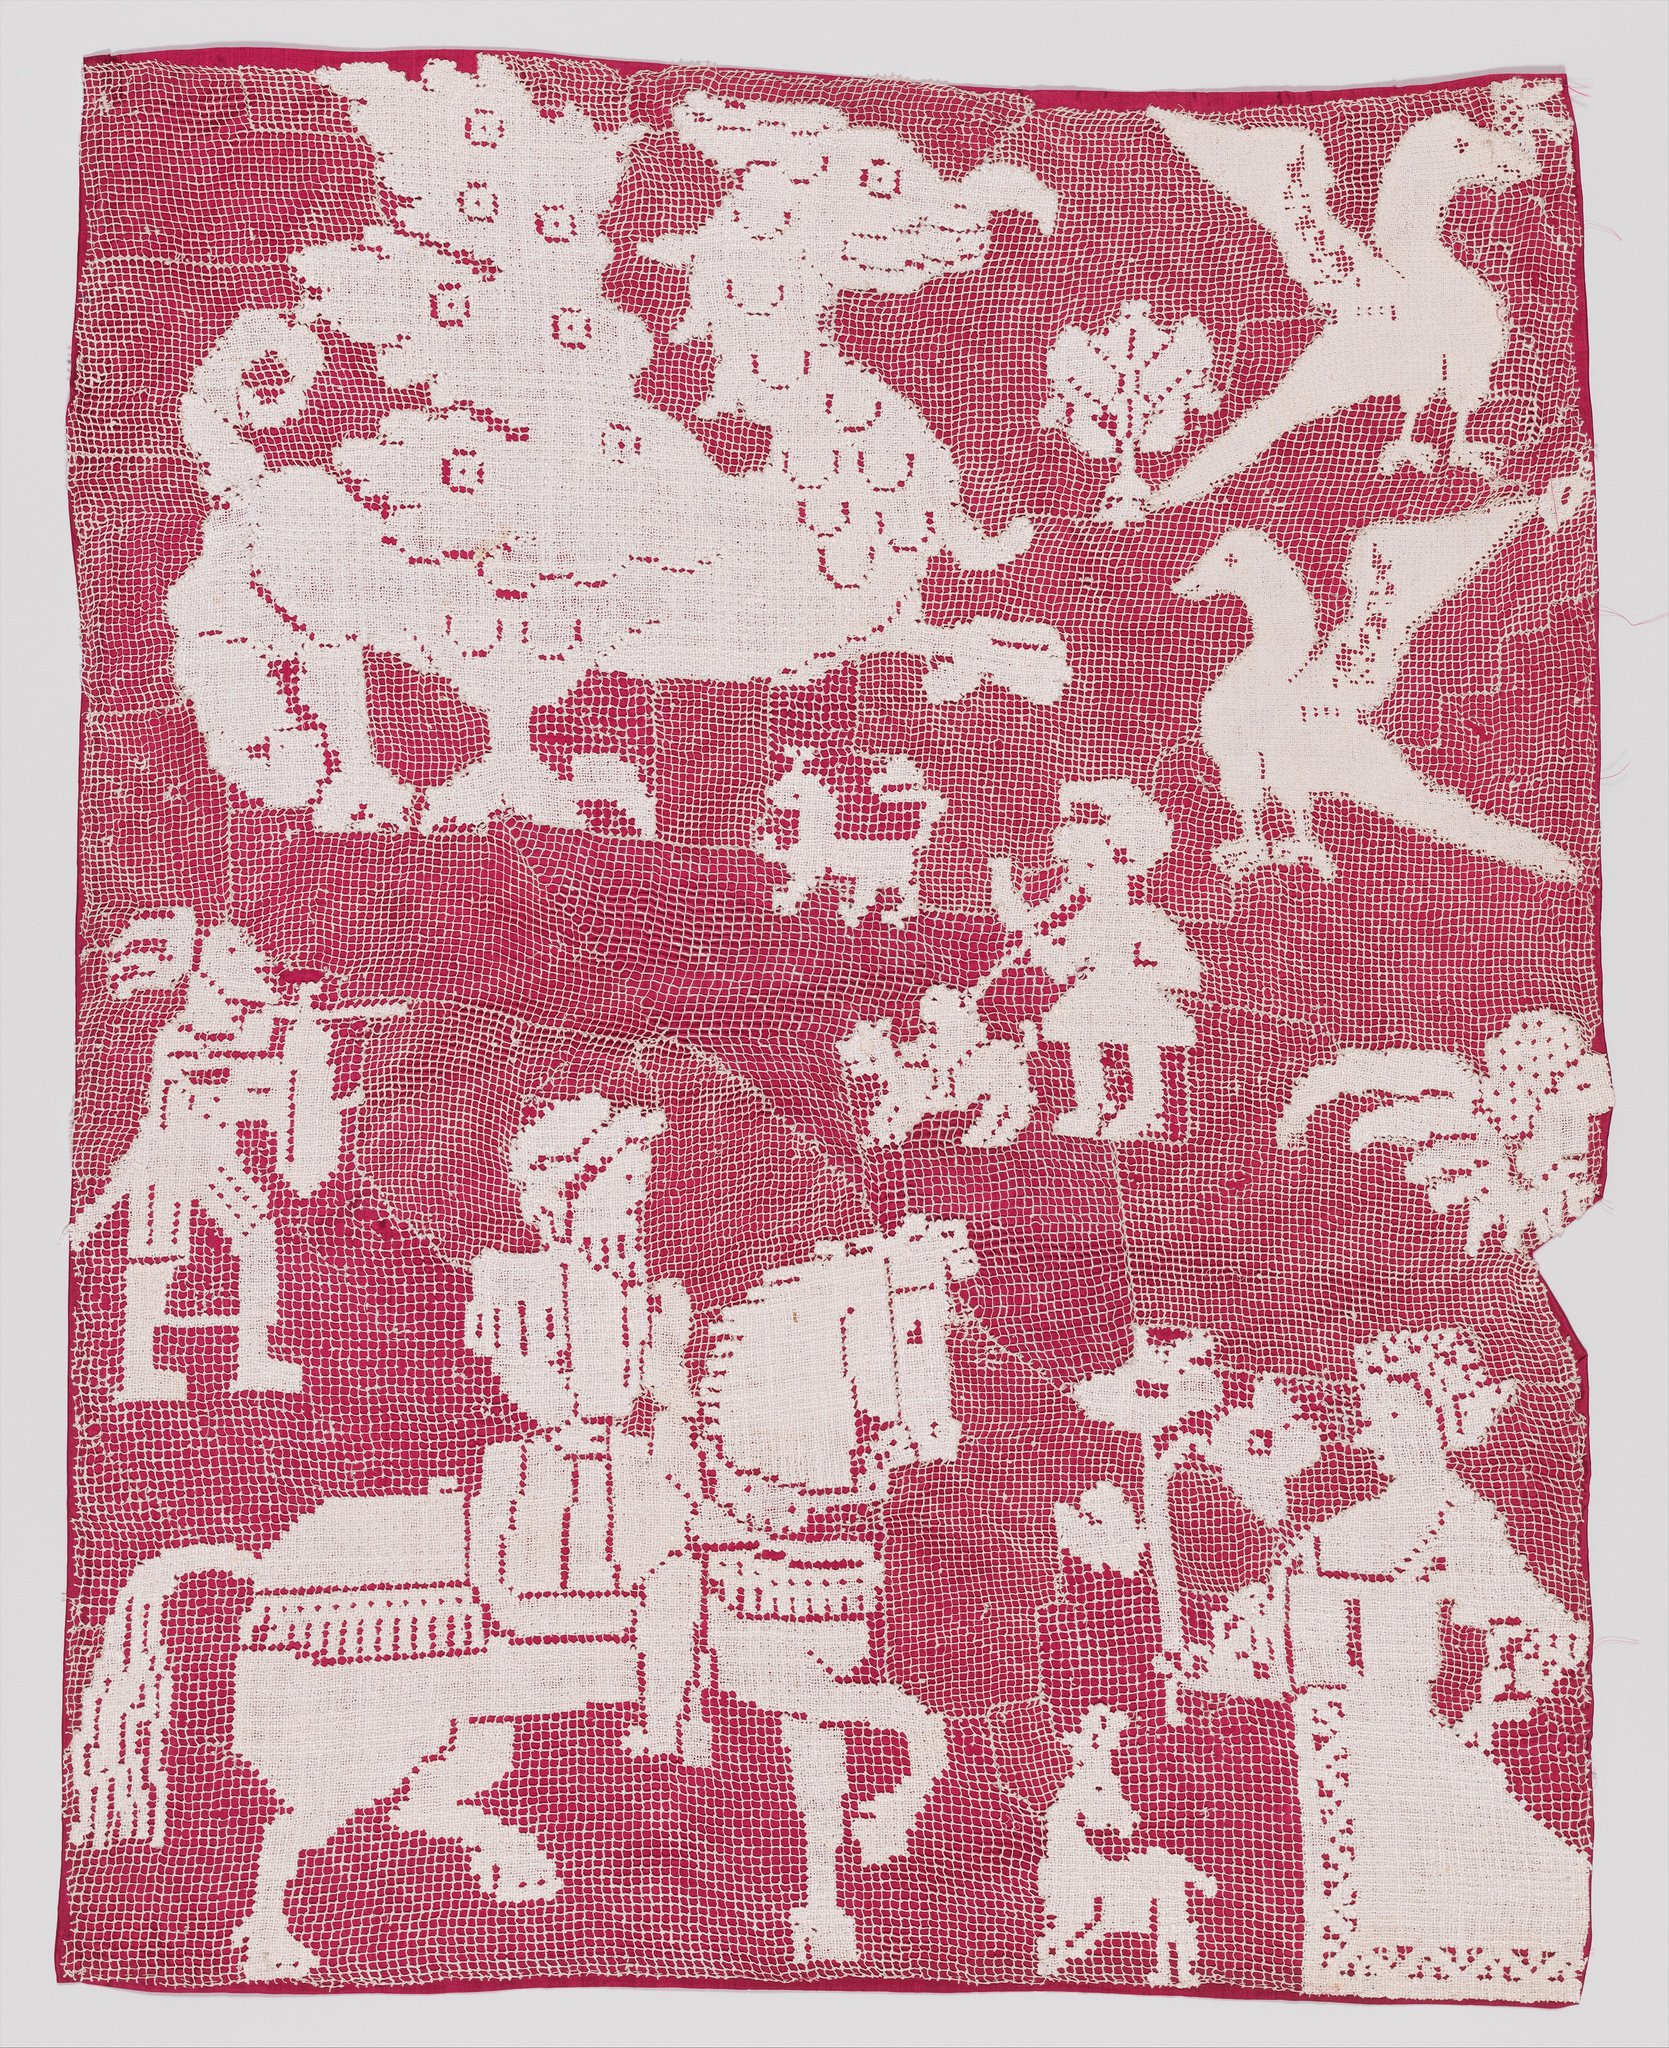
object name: fragment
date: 1501-1600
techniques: embroidery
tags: men,women,dragons,horses